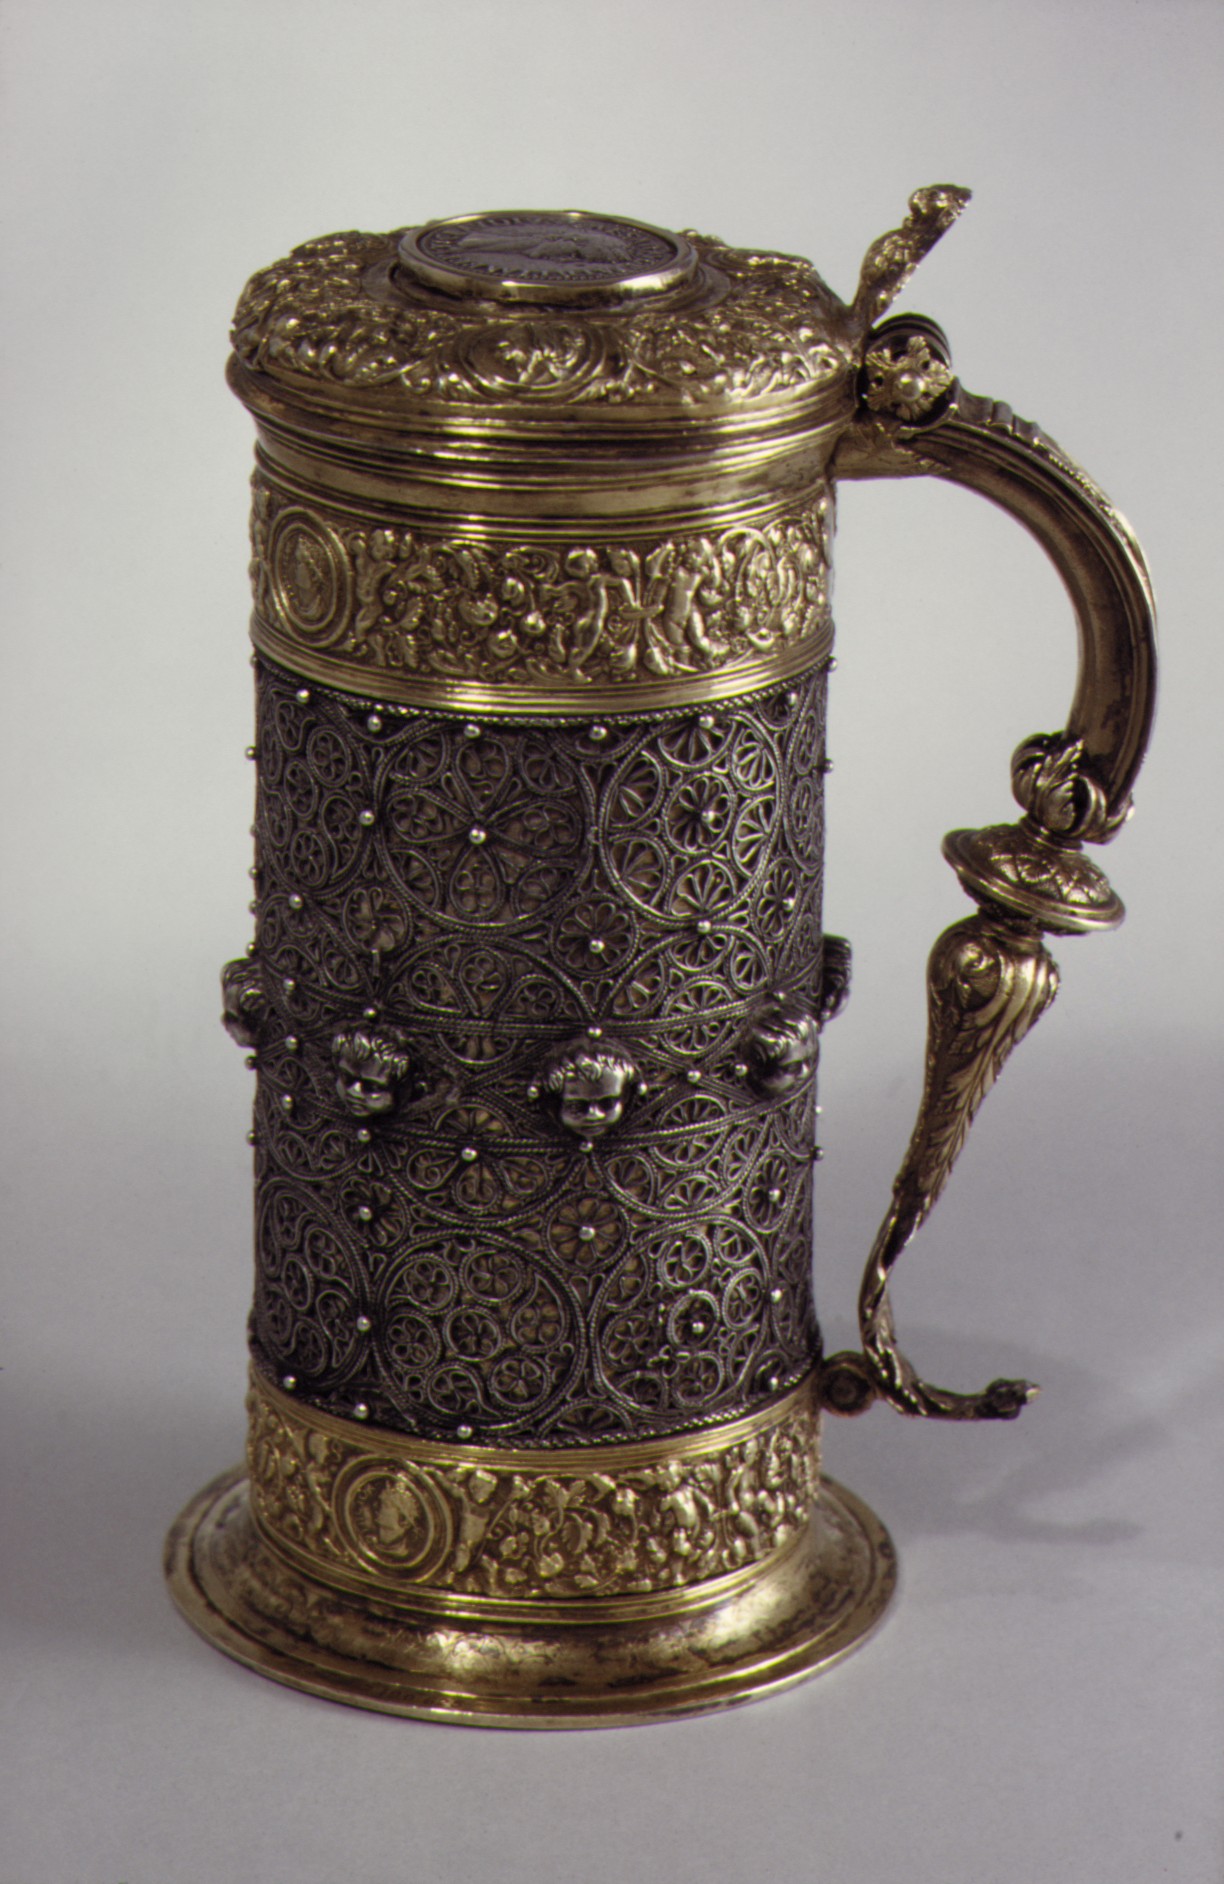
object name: tankard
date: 1801-1900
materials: gilt, silver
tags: faces